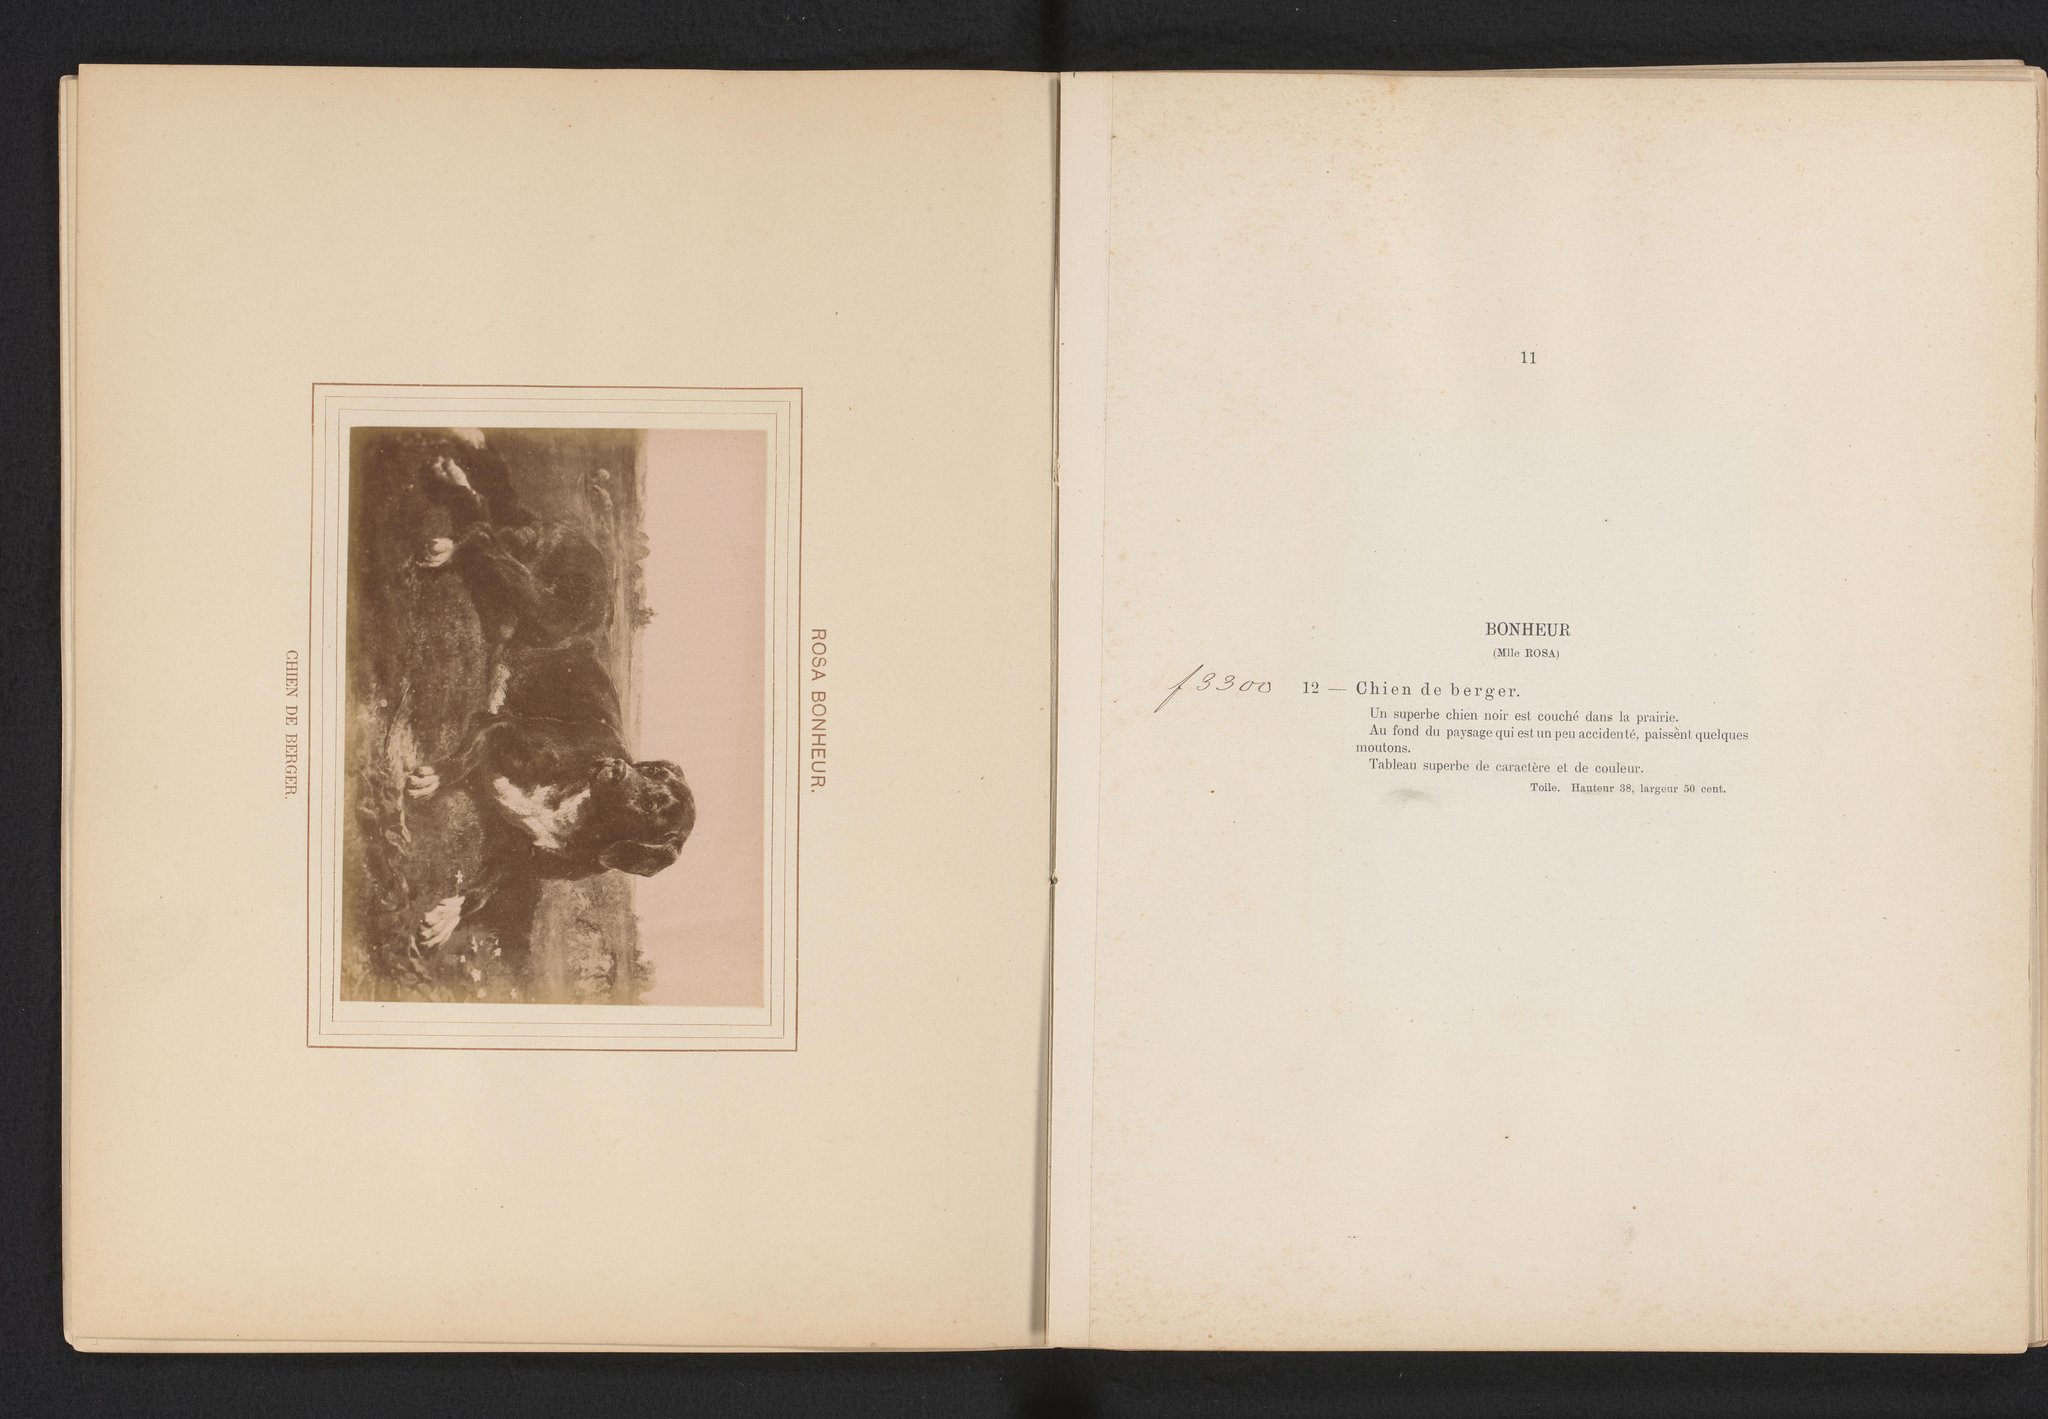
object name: page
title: Chien de Berger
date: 1878-1883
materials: photographic support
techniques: albumen print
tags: dog, painting, drawing and the graphic arts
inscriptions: inscription: ‘Rosa Bonheur’